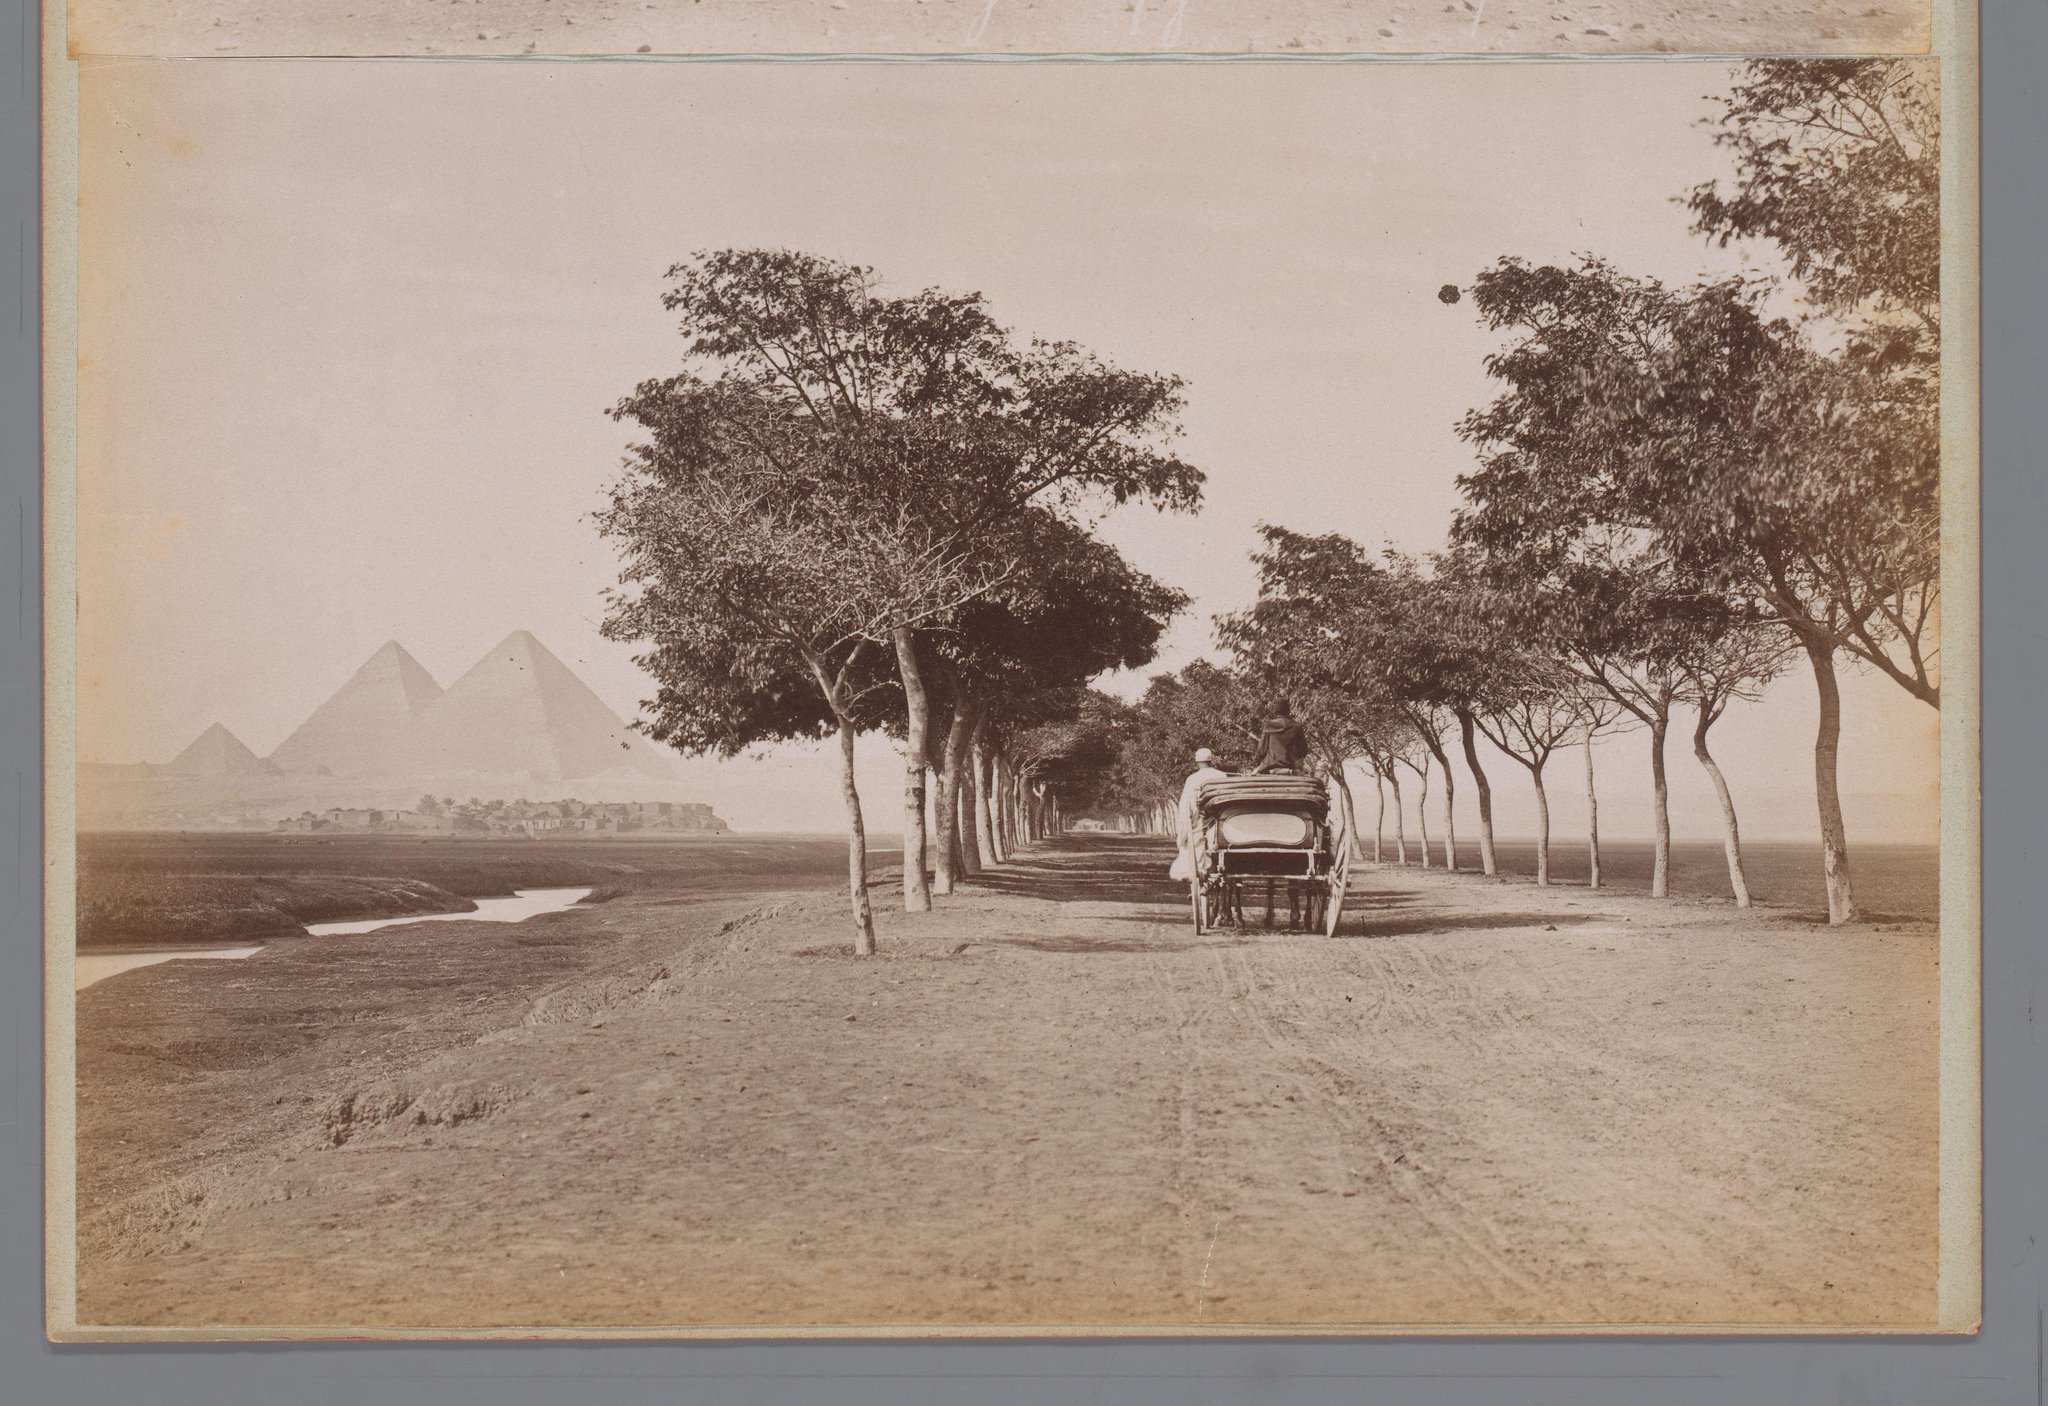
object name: photograph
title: Grande pyramide de Chéops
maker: félix bonfils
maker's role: fotograaf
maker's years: 1831-1885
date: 1867-1885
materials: cardboard, paper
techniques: albumen print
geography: gizeh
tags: pyramid (historical grave form)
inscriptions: number: ‘113’